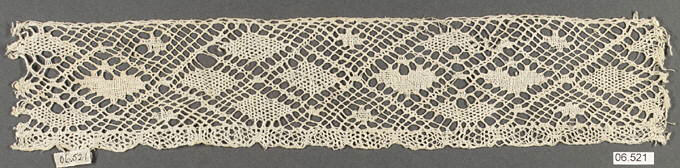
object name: fragment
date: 1801-1833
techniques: lace